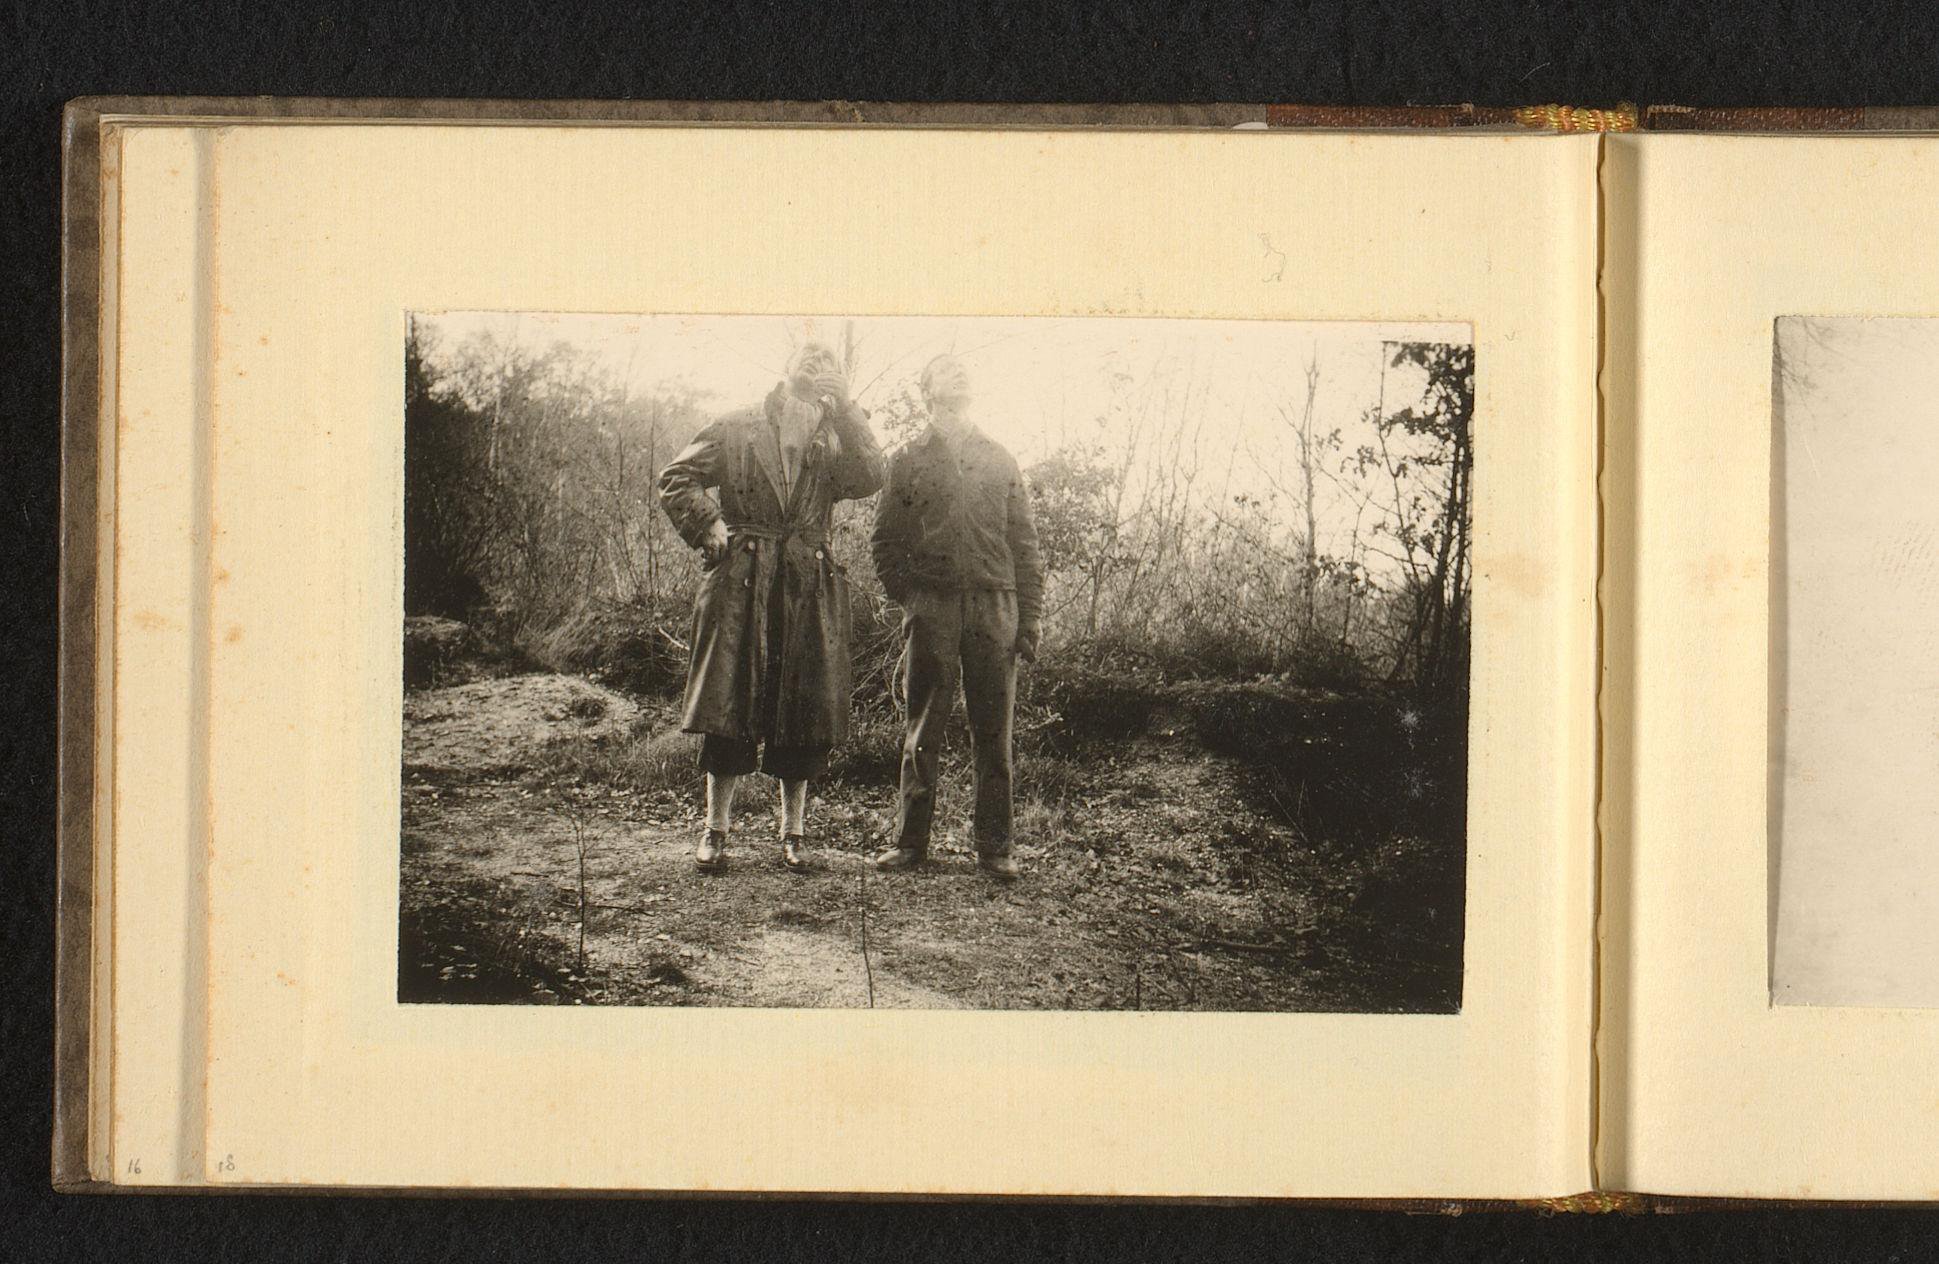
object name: photograph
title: Twee mannen in een bos, kijkend naar boven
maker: norbert van den berg (1901-1972)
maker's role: amateurfotograaf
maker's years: 1901-1972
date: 1935-1950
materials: paper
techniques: gelatin silver print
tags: adult man, forest, wood